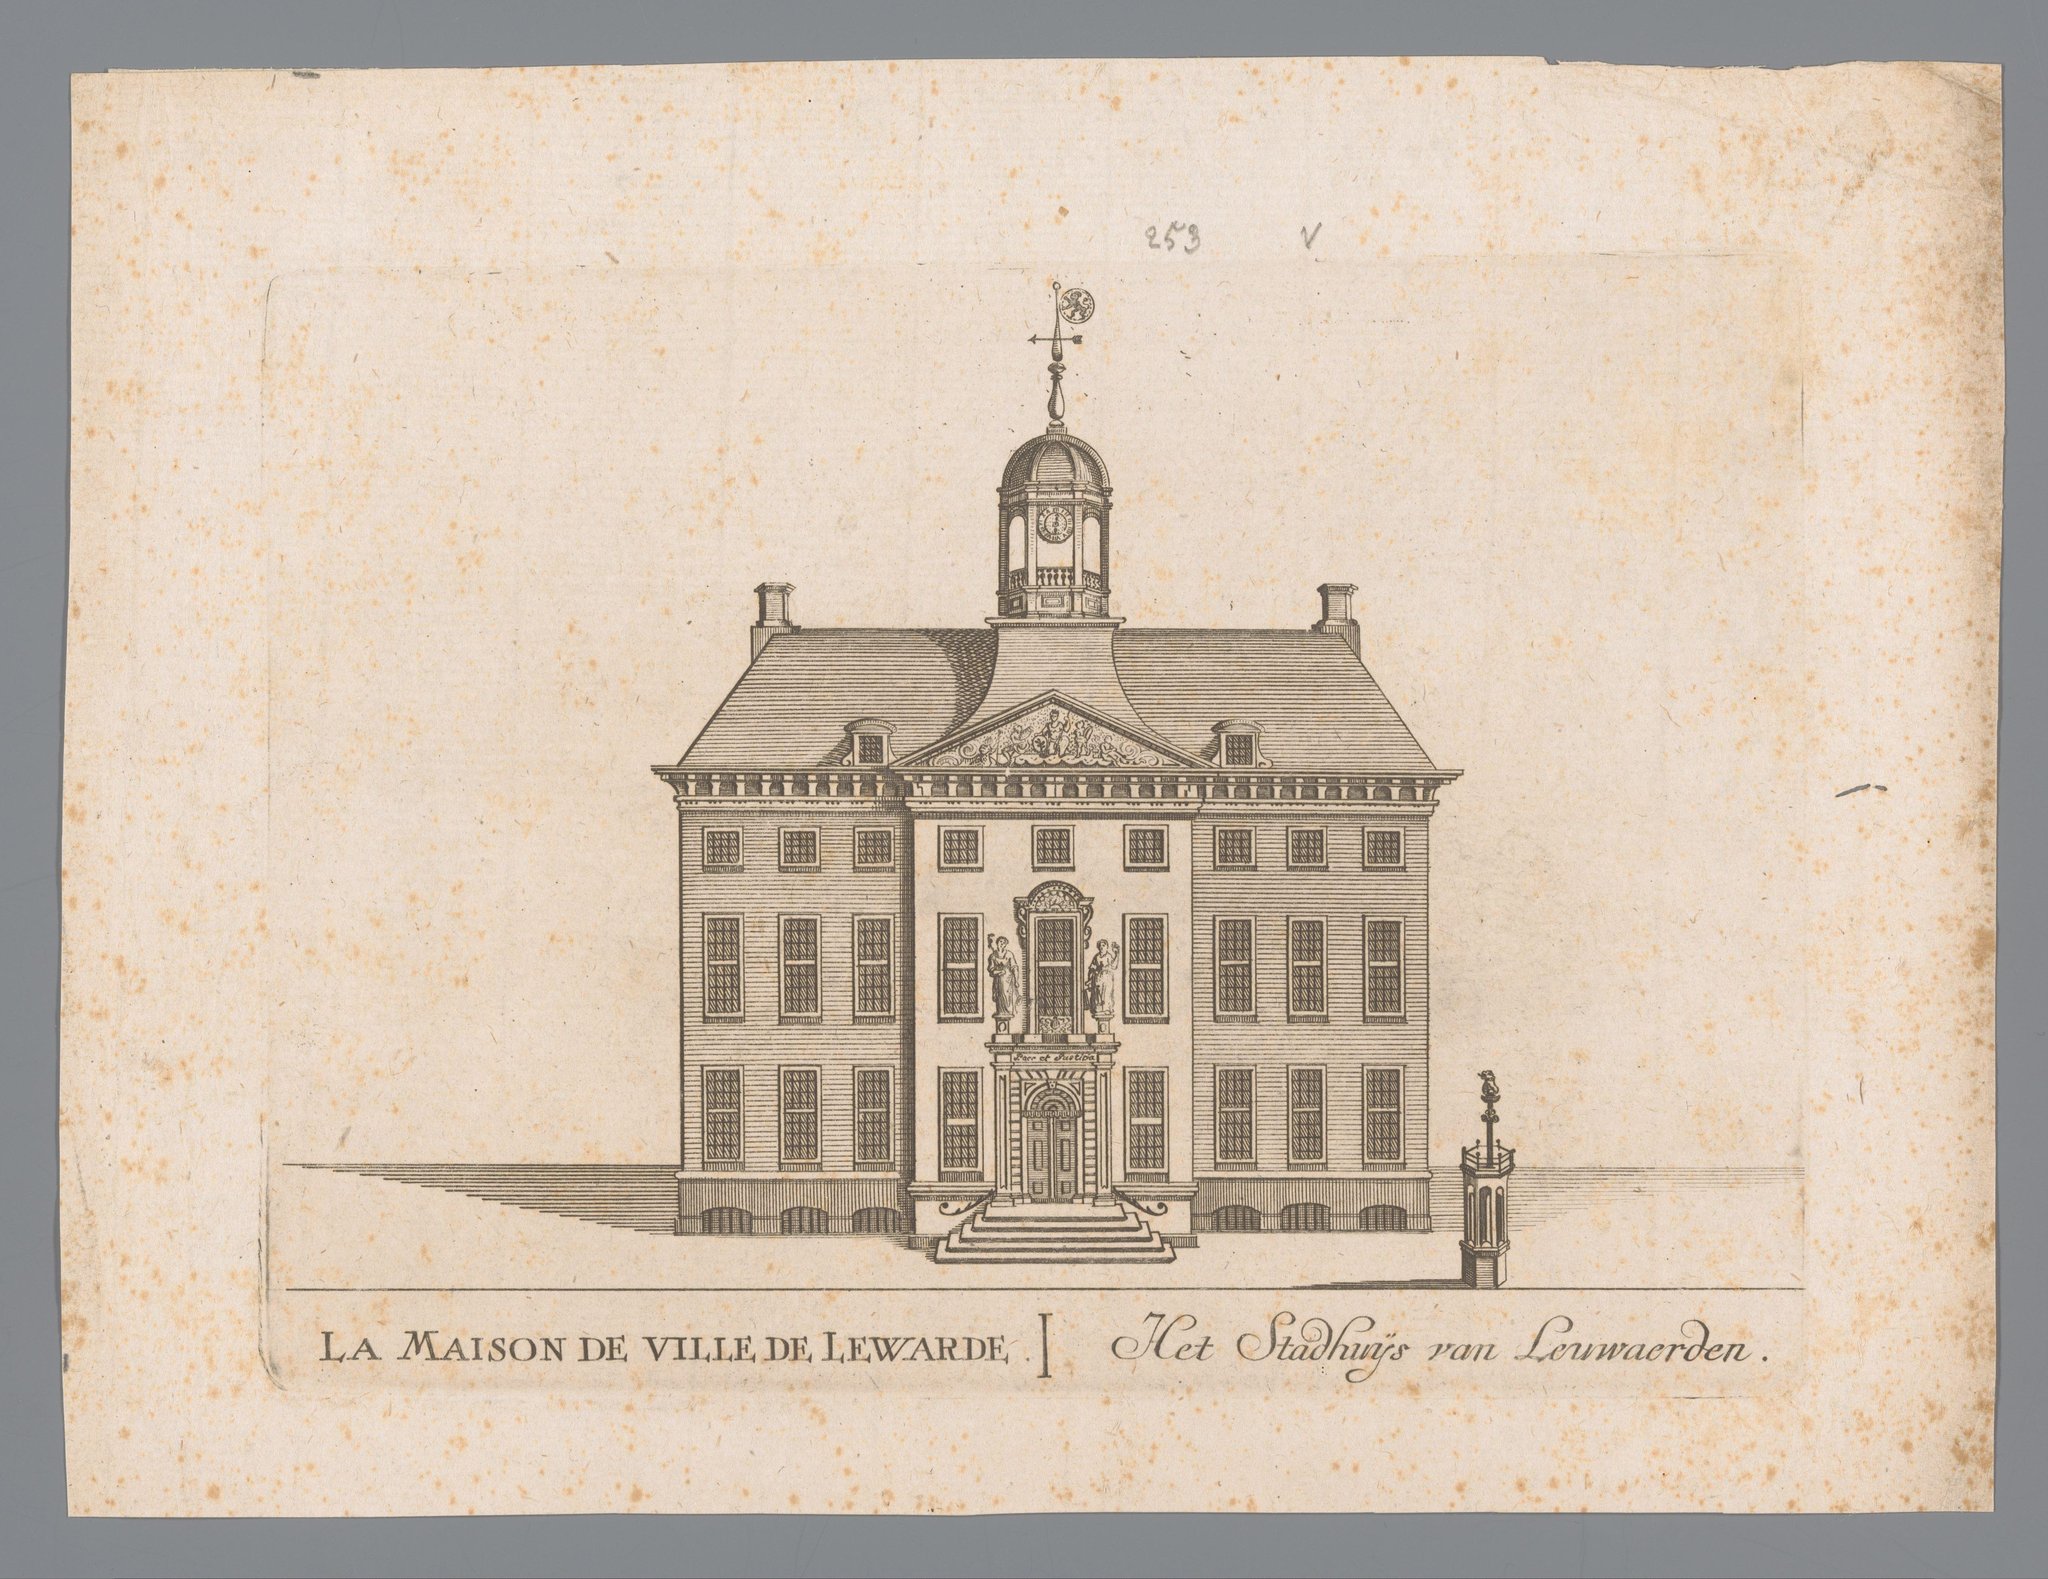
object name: print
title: La Maison de ville de Lewarde / Het Stadhuijs van Leuwaerden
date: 1720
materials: paper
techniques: engraving, etching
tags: townhall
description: Latere staat onder andere verschenen in: Histoire Generale des Pais bas Contenant la Description des XVII Provinces. Brussel: Francois Foppens, 1720.